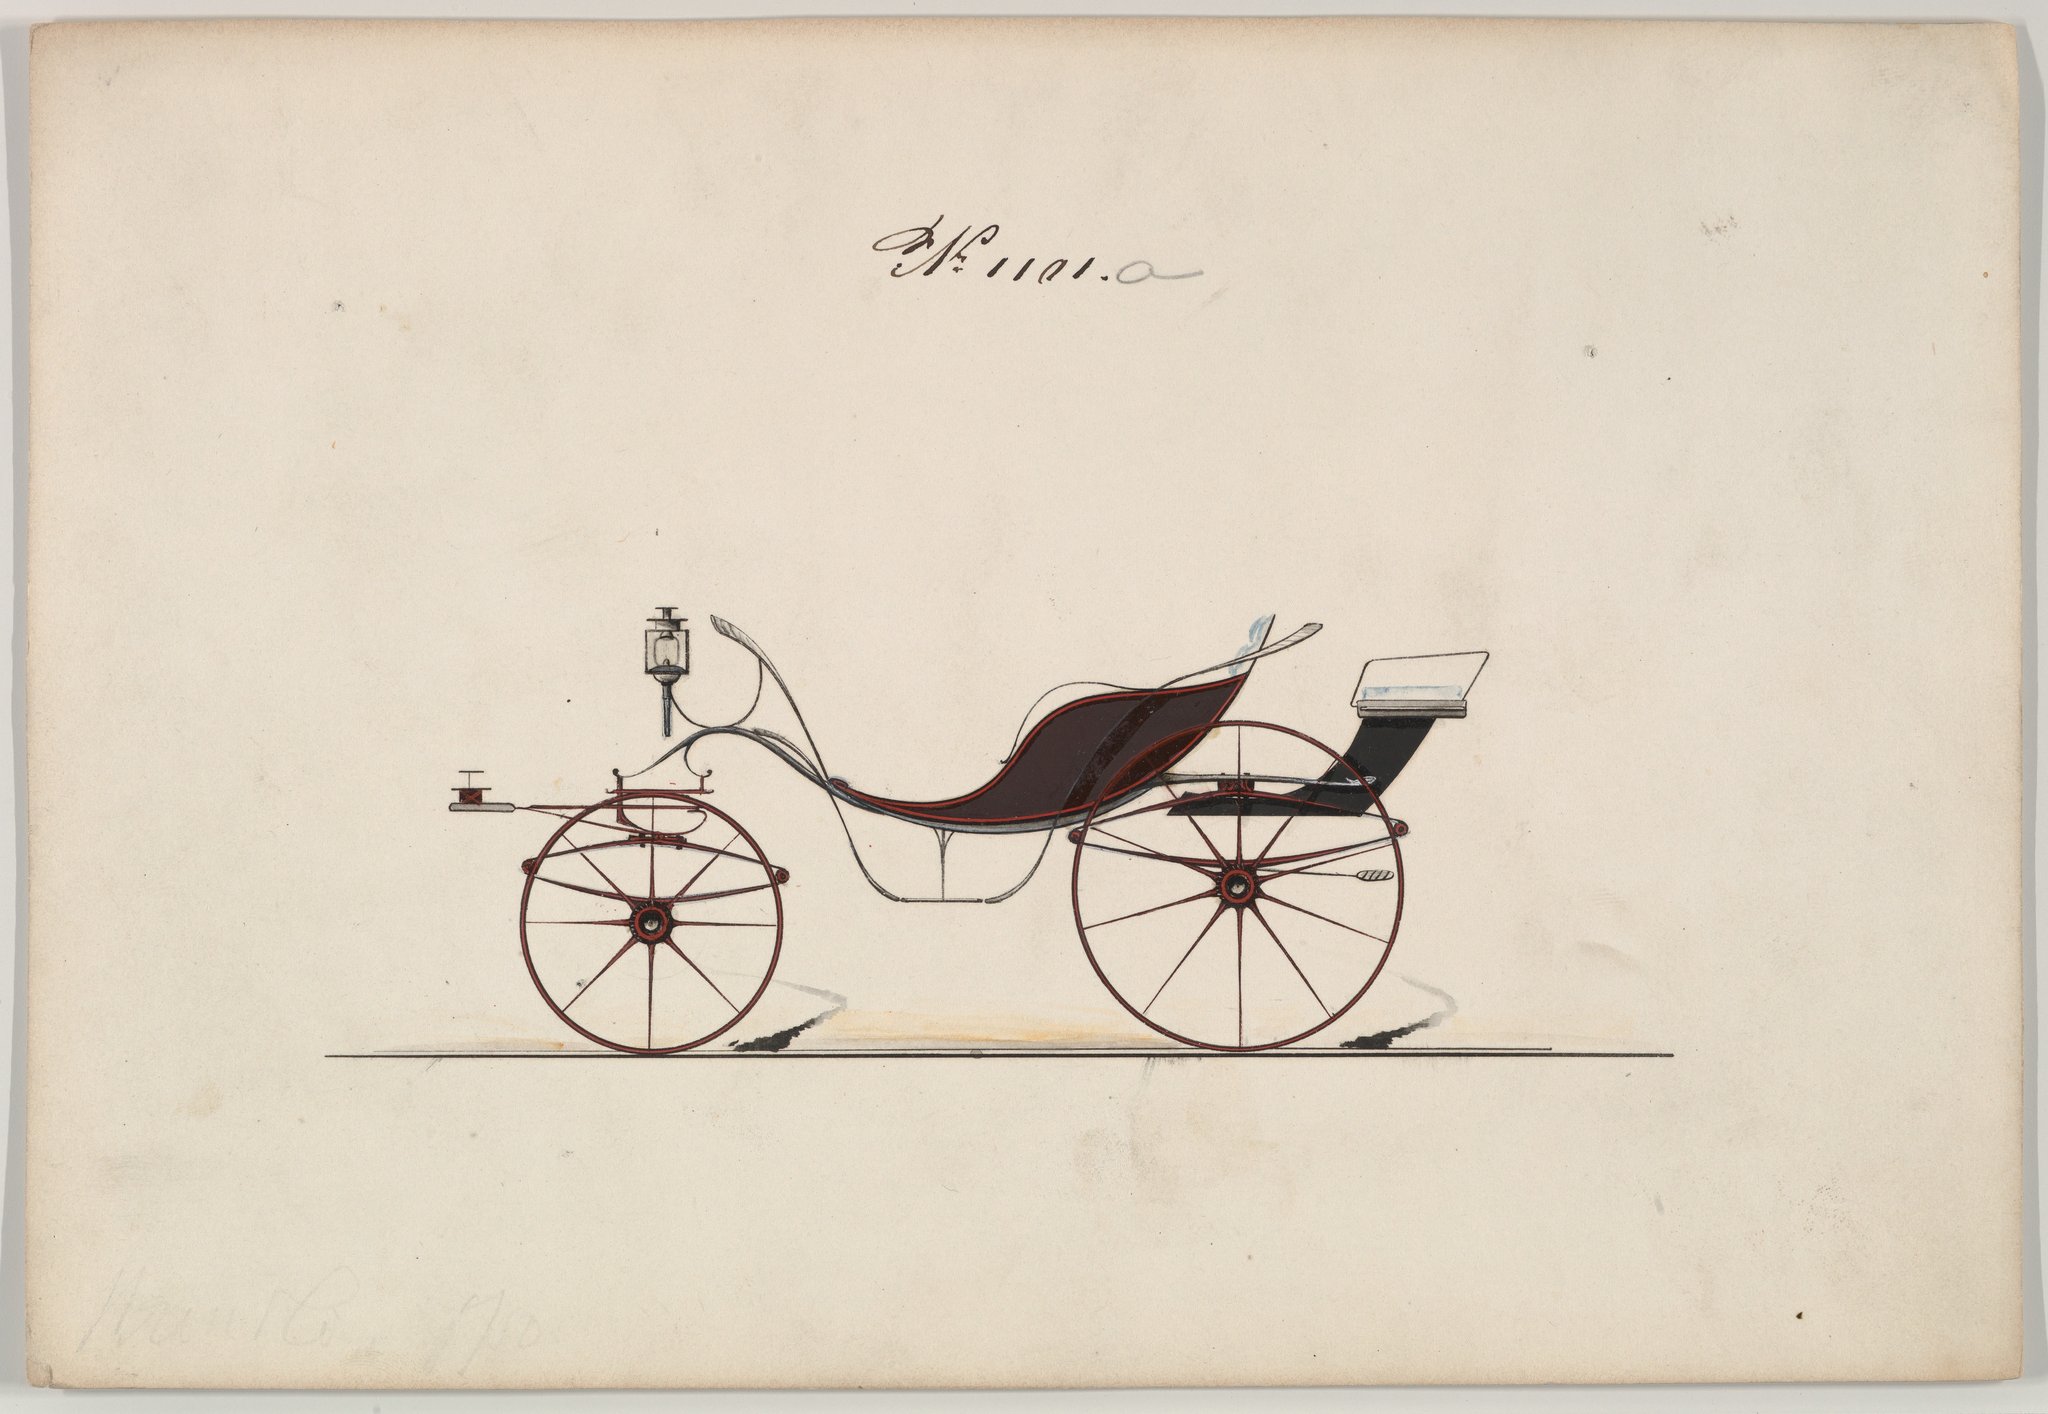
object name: drawing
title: Phaeton #1101a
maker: brewster & co.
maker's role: manufacturer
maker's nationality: american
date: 1870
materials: gouache, gum arabic, ink, watercolor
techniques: pen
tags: carriages